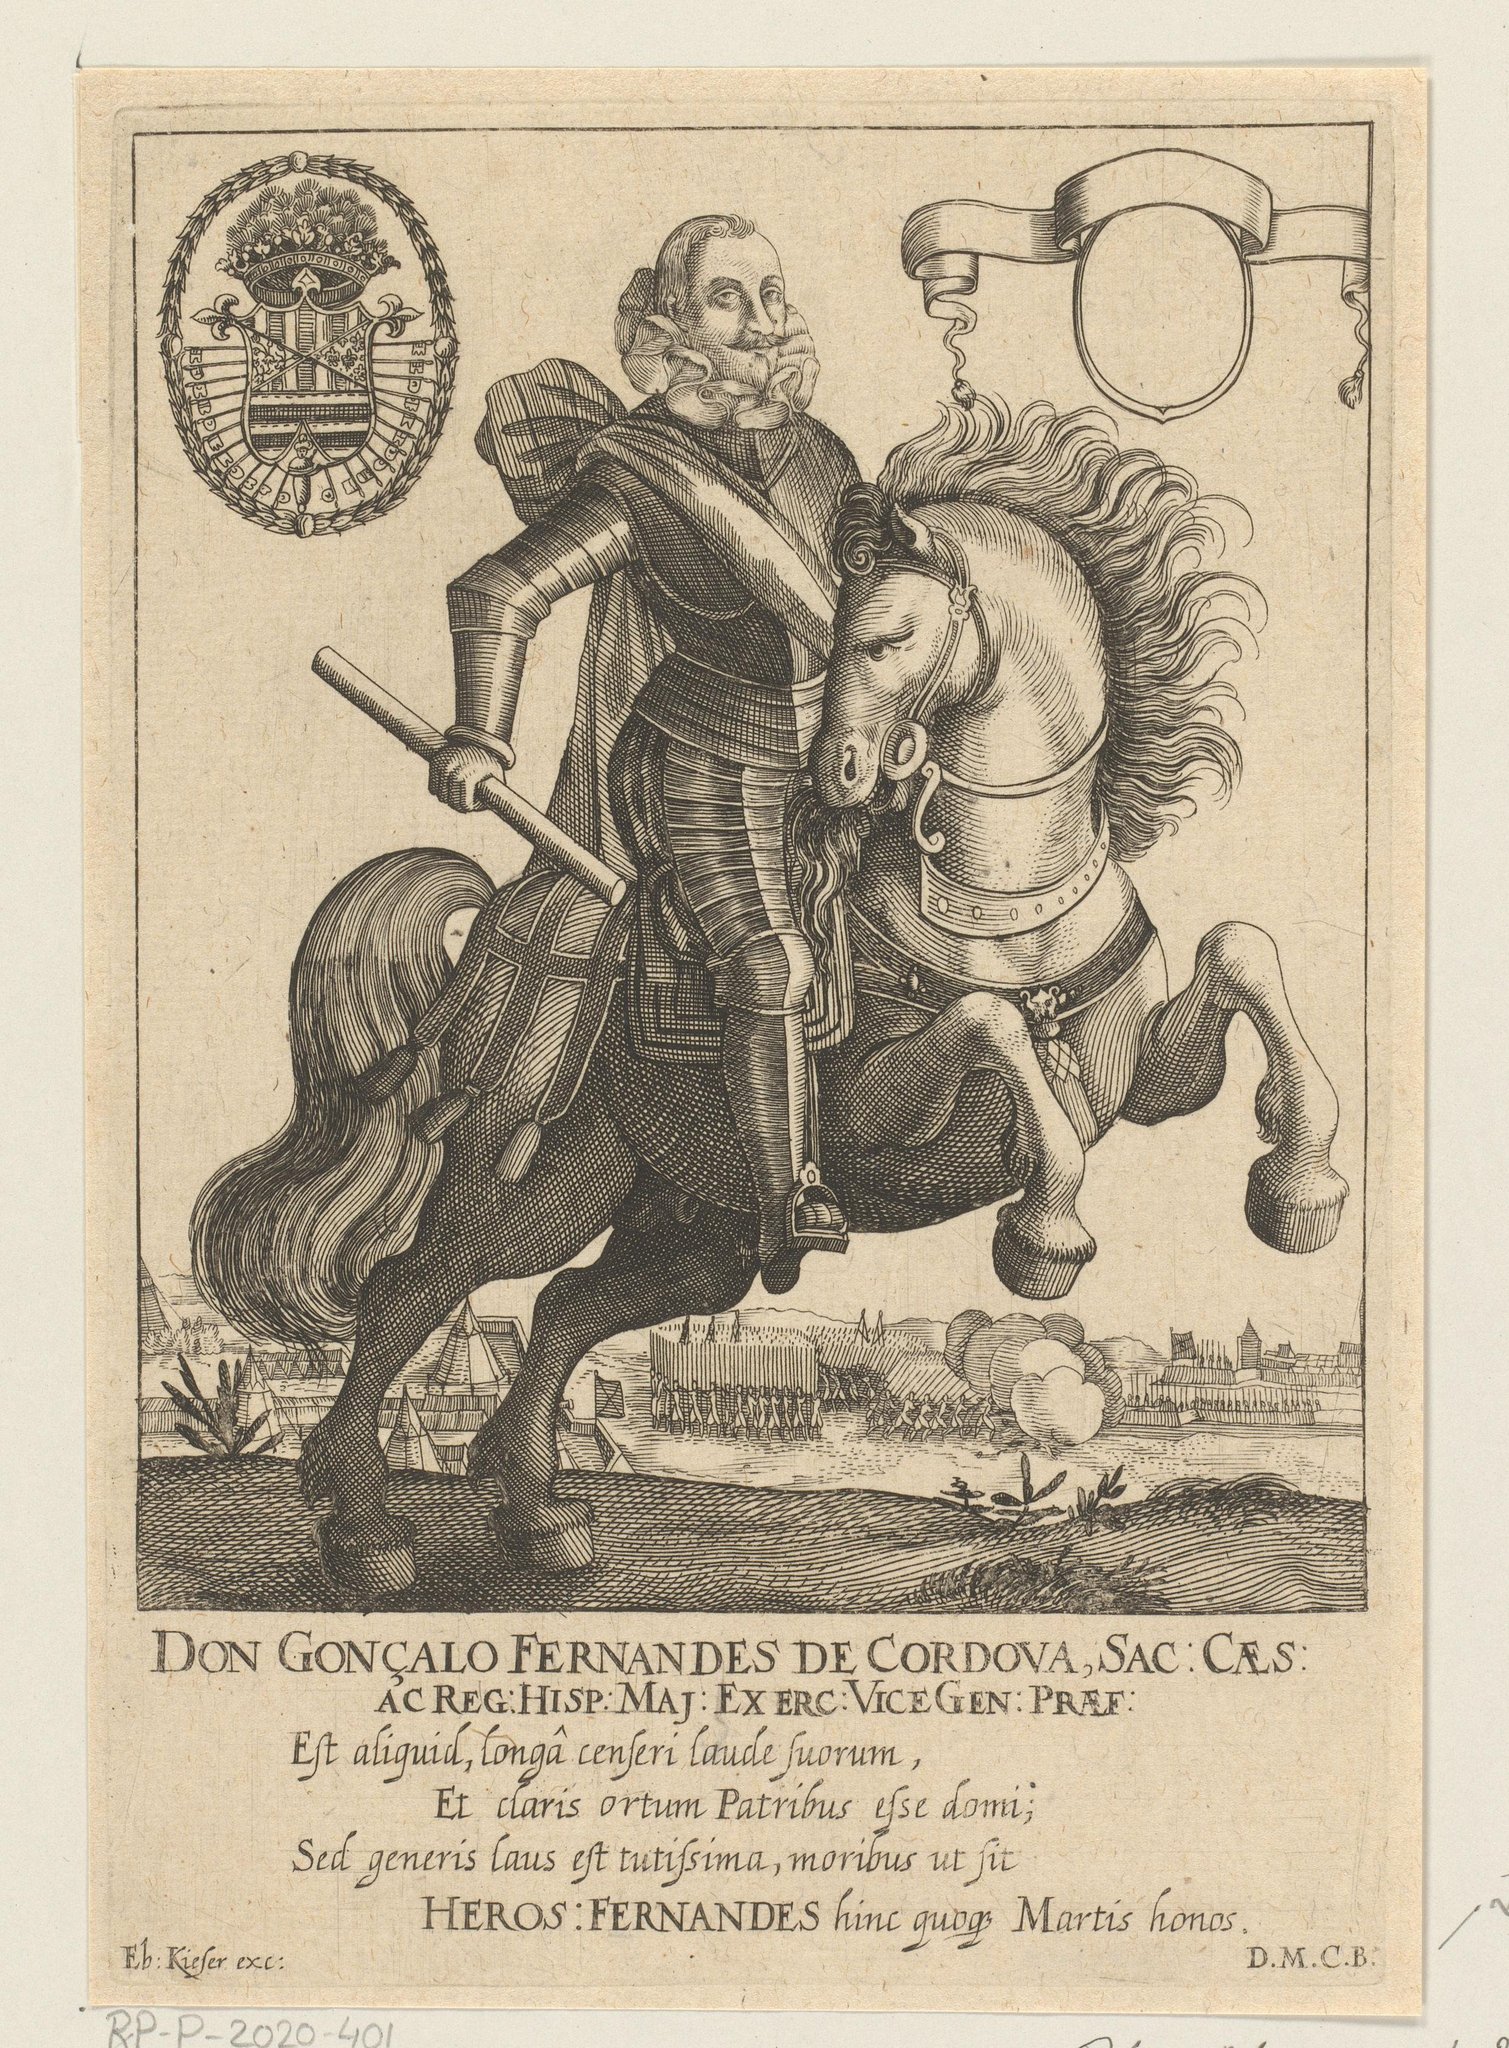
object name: print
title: Portret van Gonzalo Fernández de Córdoba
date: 1609-1631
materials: paper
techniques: engraving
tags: horse throwing rider, historical persons, armorial bearing, heraldry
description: Met rechts naast het hoofd zijn wapenschild.